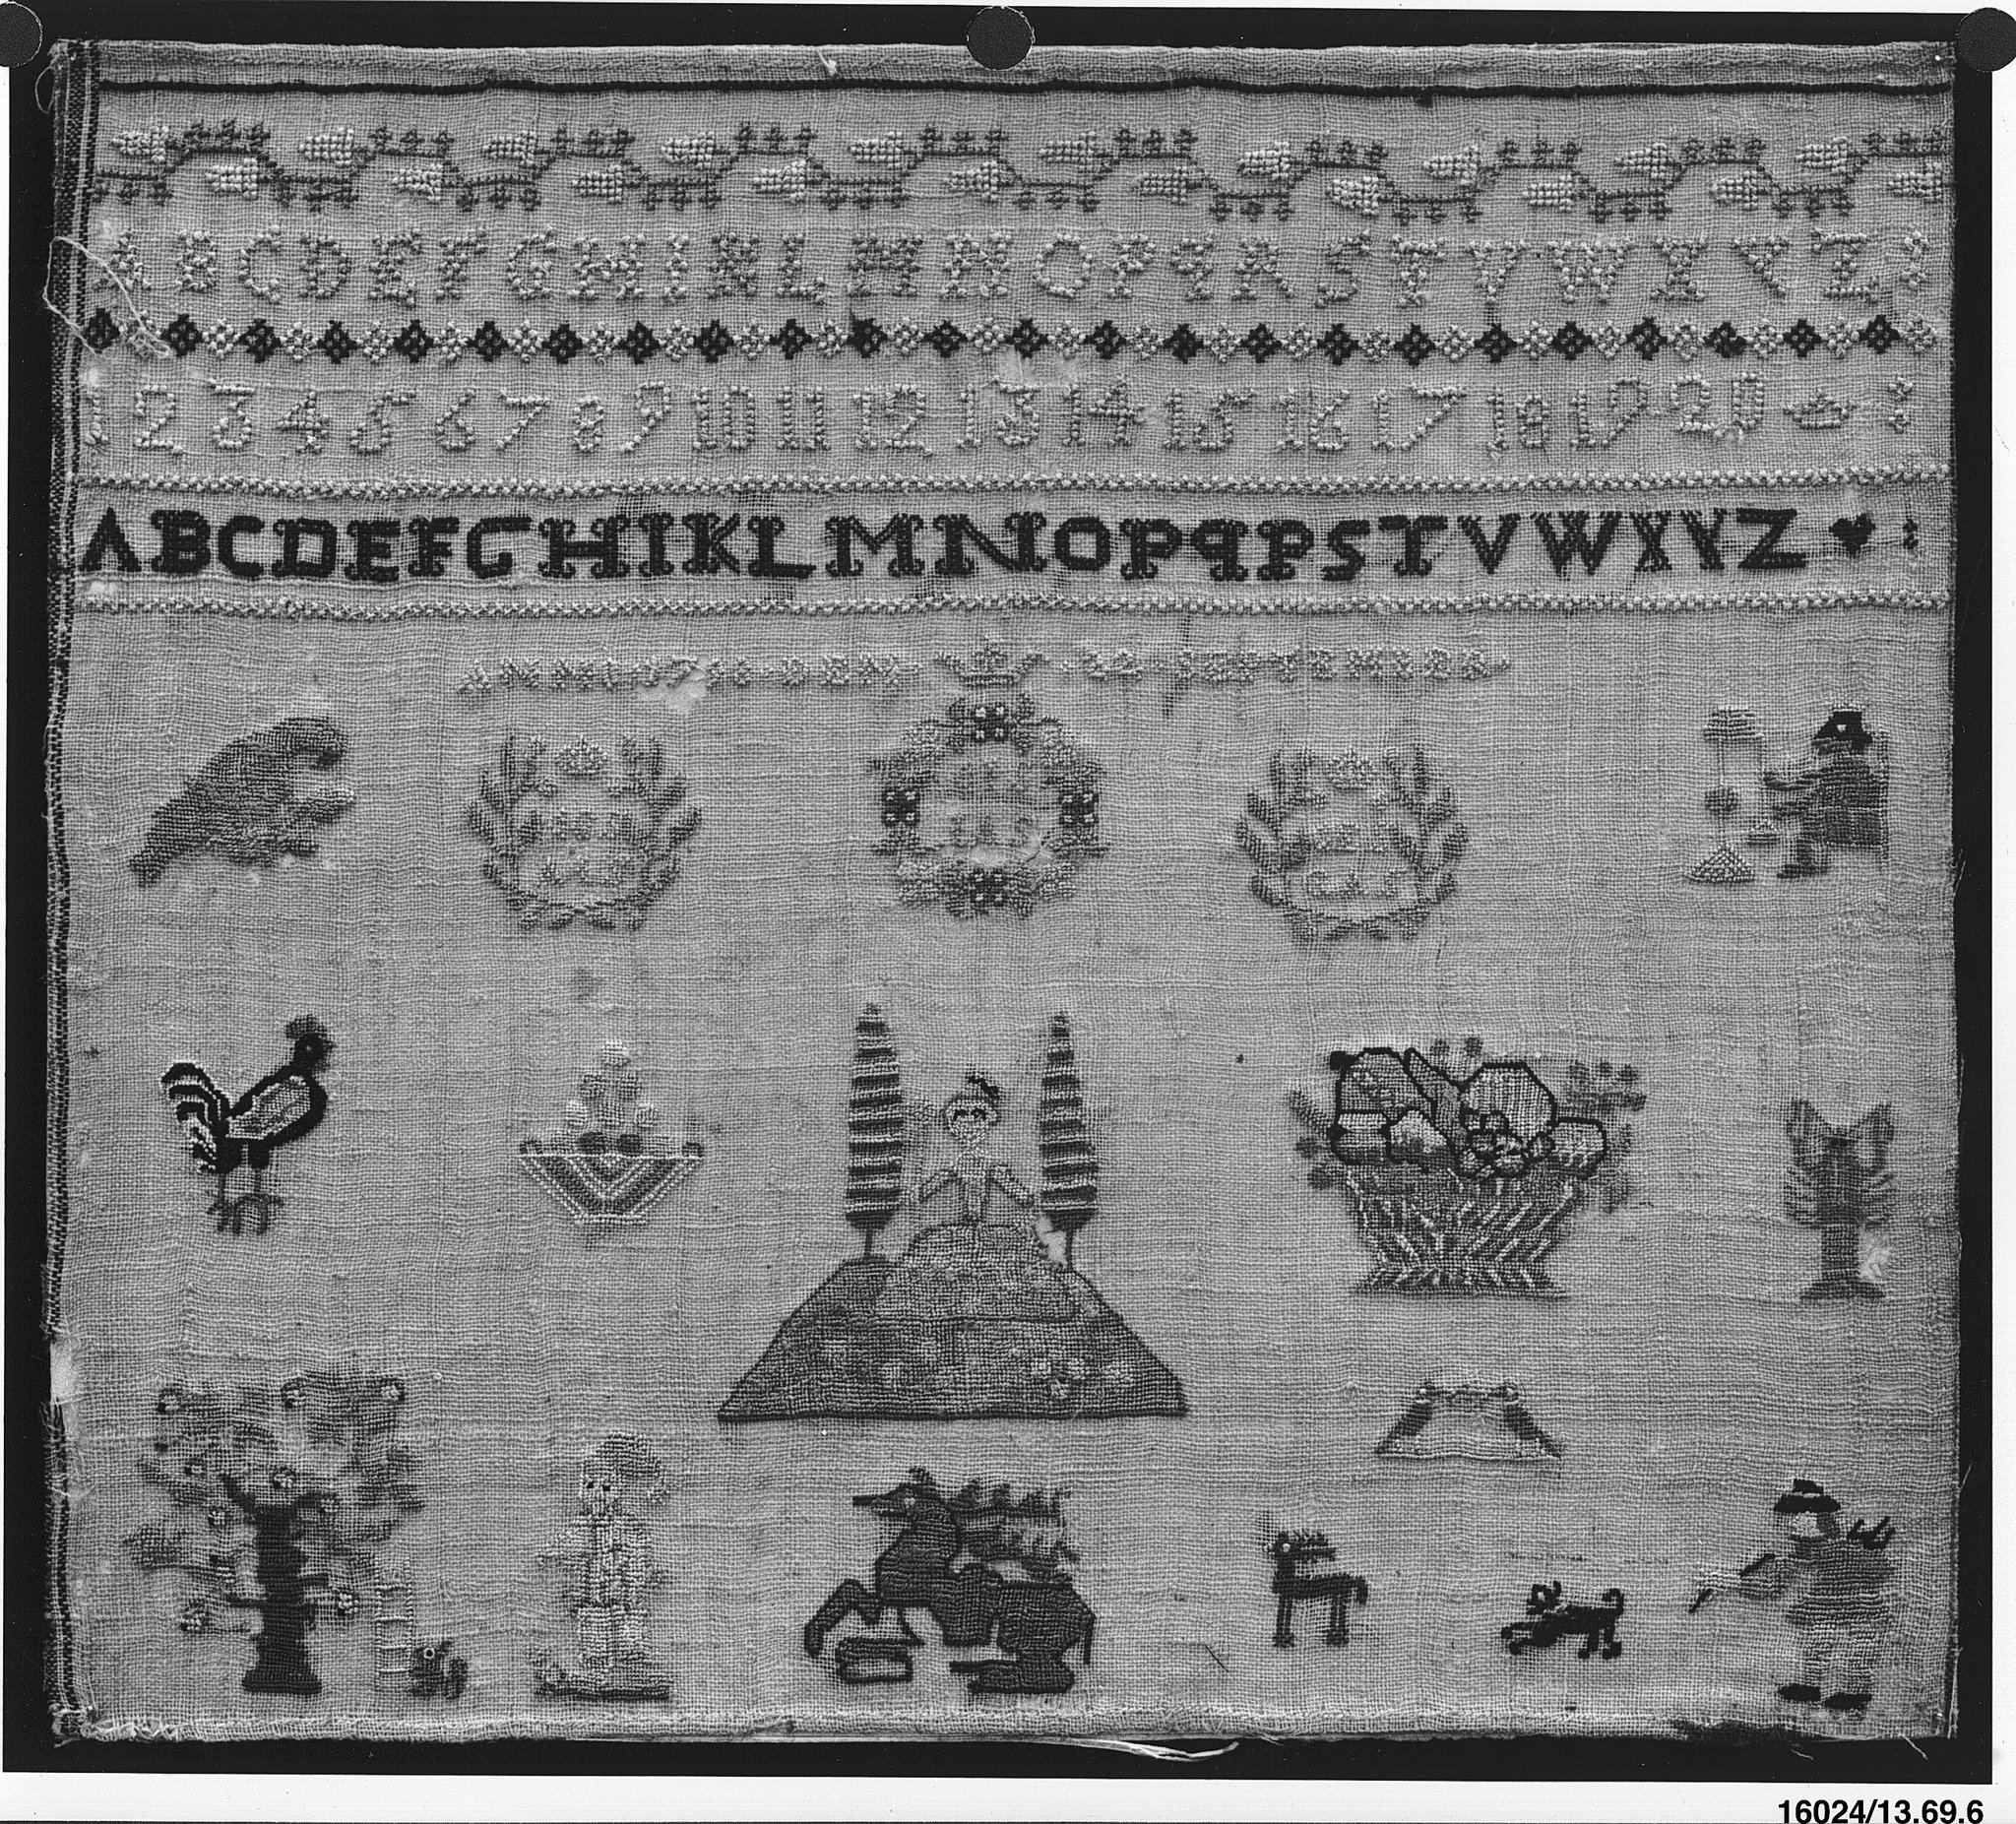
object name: sampler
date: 1798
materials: canvas, silk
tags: animals,birds